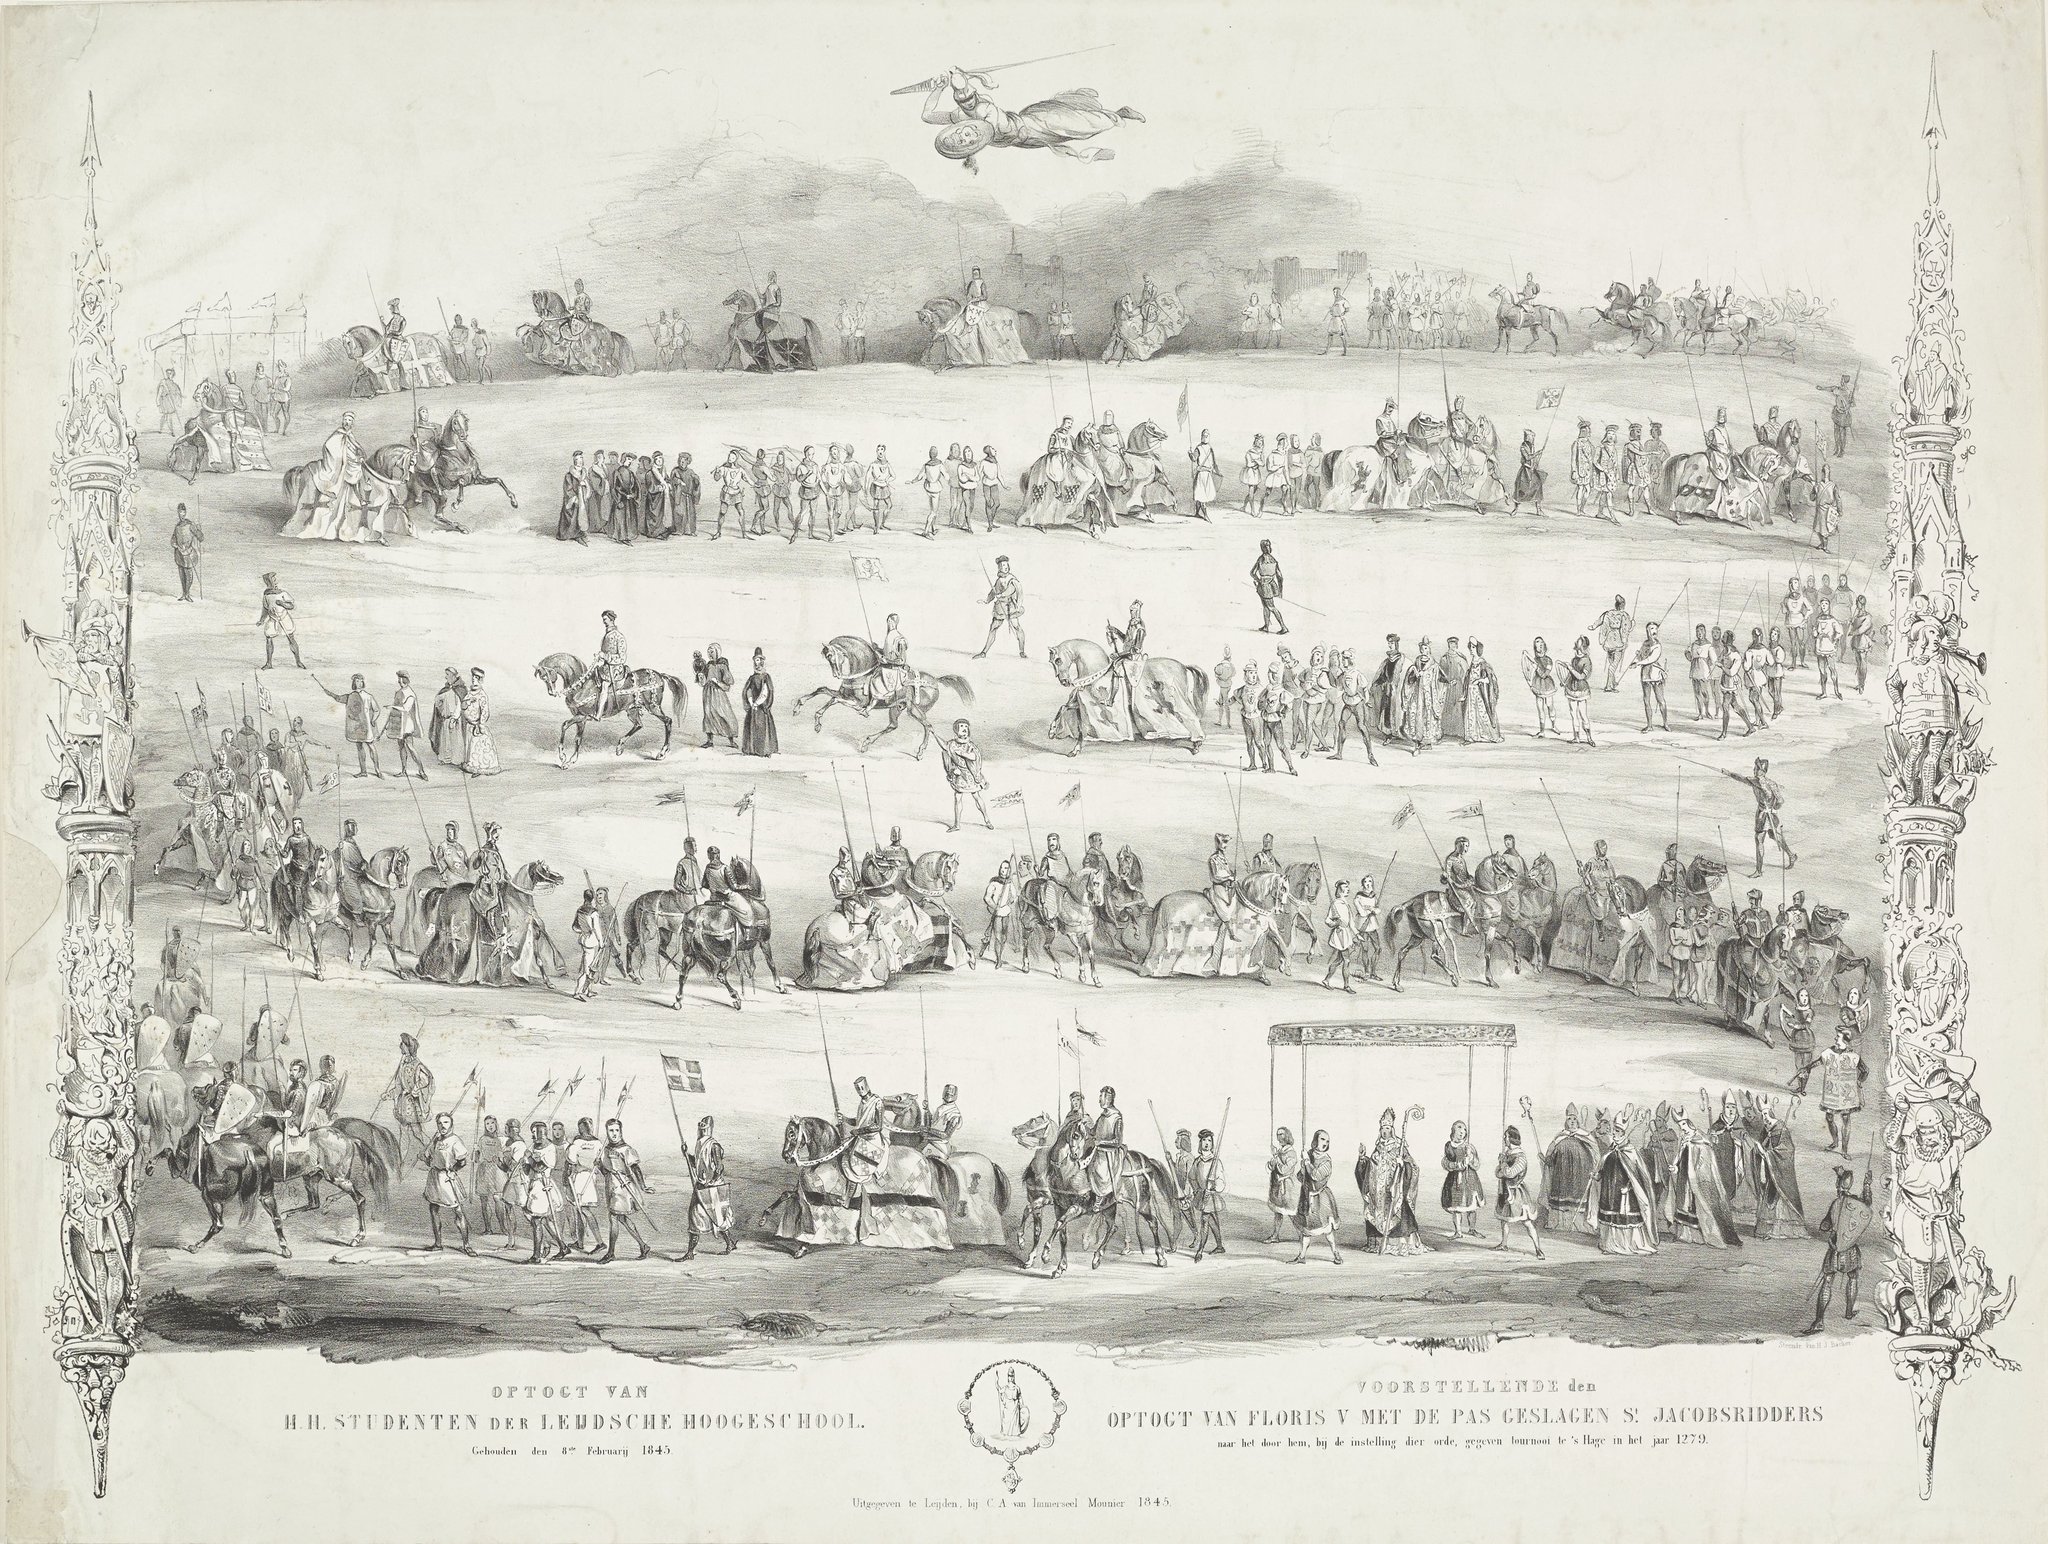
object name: print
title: Optogt van H.H. Studenten der Leijdsche Hoogeschool. Gehouden den 8ste Februarij 1845. Voorstellende den Optogt van Floris V met de pas geslagen St. Jacobsridders naar het door hem, bij de instelling dier orde, gegeven tournooi te 's Hage in het jaar 1279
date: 1845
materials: paper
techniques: lithograph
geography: leiden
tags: floris v (graaf van holland en zeeland), students' pageant, costumes used in pageants, leiden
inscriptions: collector's mark: Lugt 2228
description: Historische gekostumeerde optocht door de studenten van Leidse Hogeschool op 8 februari 1845, ter viering van de 270ste verjaardag van de universiteit. Het onderwerp van de historische optocht en maskerade is de optocht van graaf Floris V met de St. Jacobsridders in Den Haag in 1279. Links en rechts twee zuilen met middeleeuwse decoraties, bovenaan vliegt Minerva door de lucht. Onderaan een keten met het insigne van de Orde van Sint Jacob.